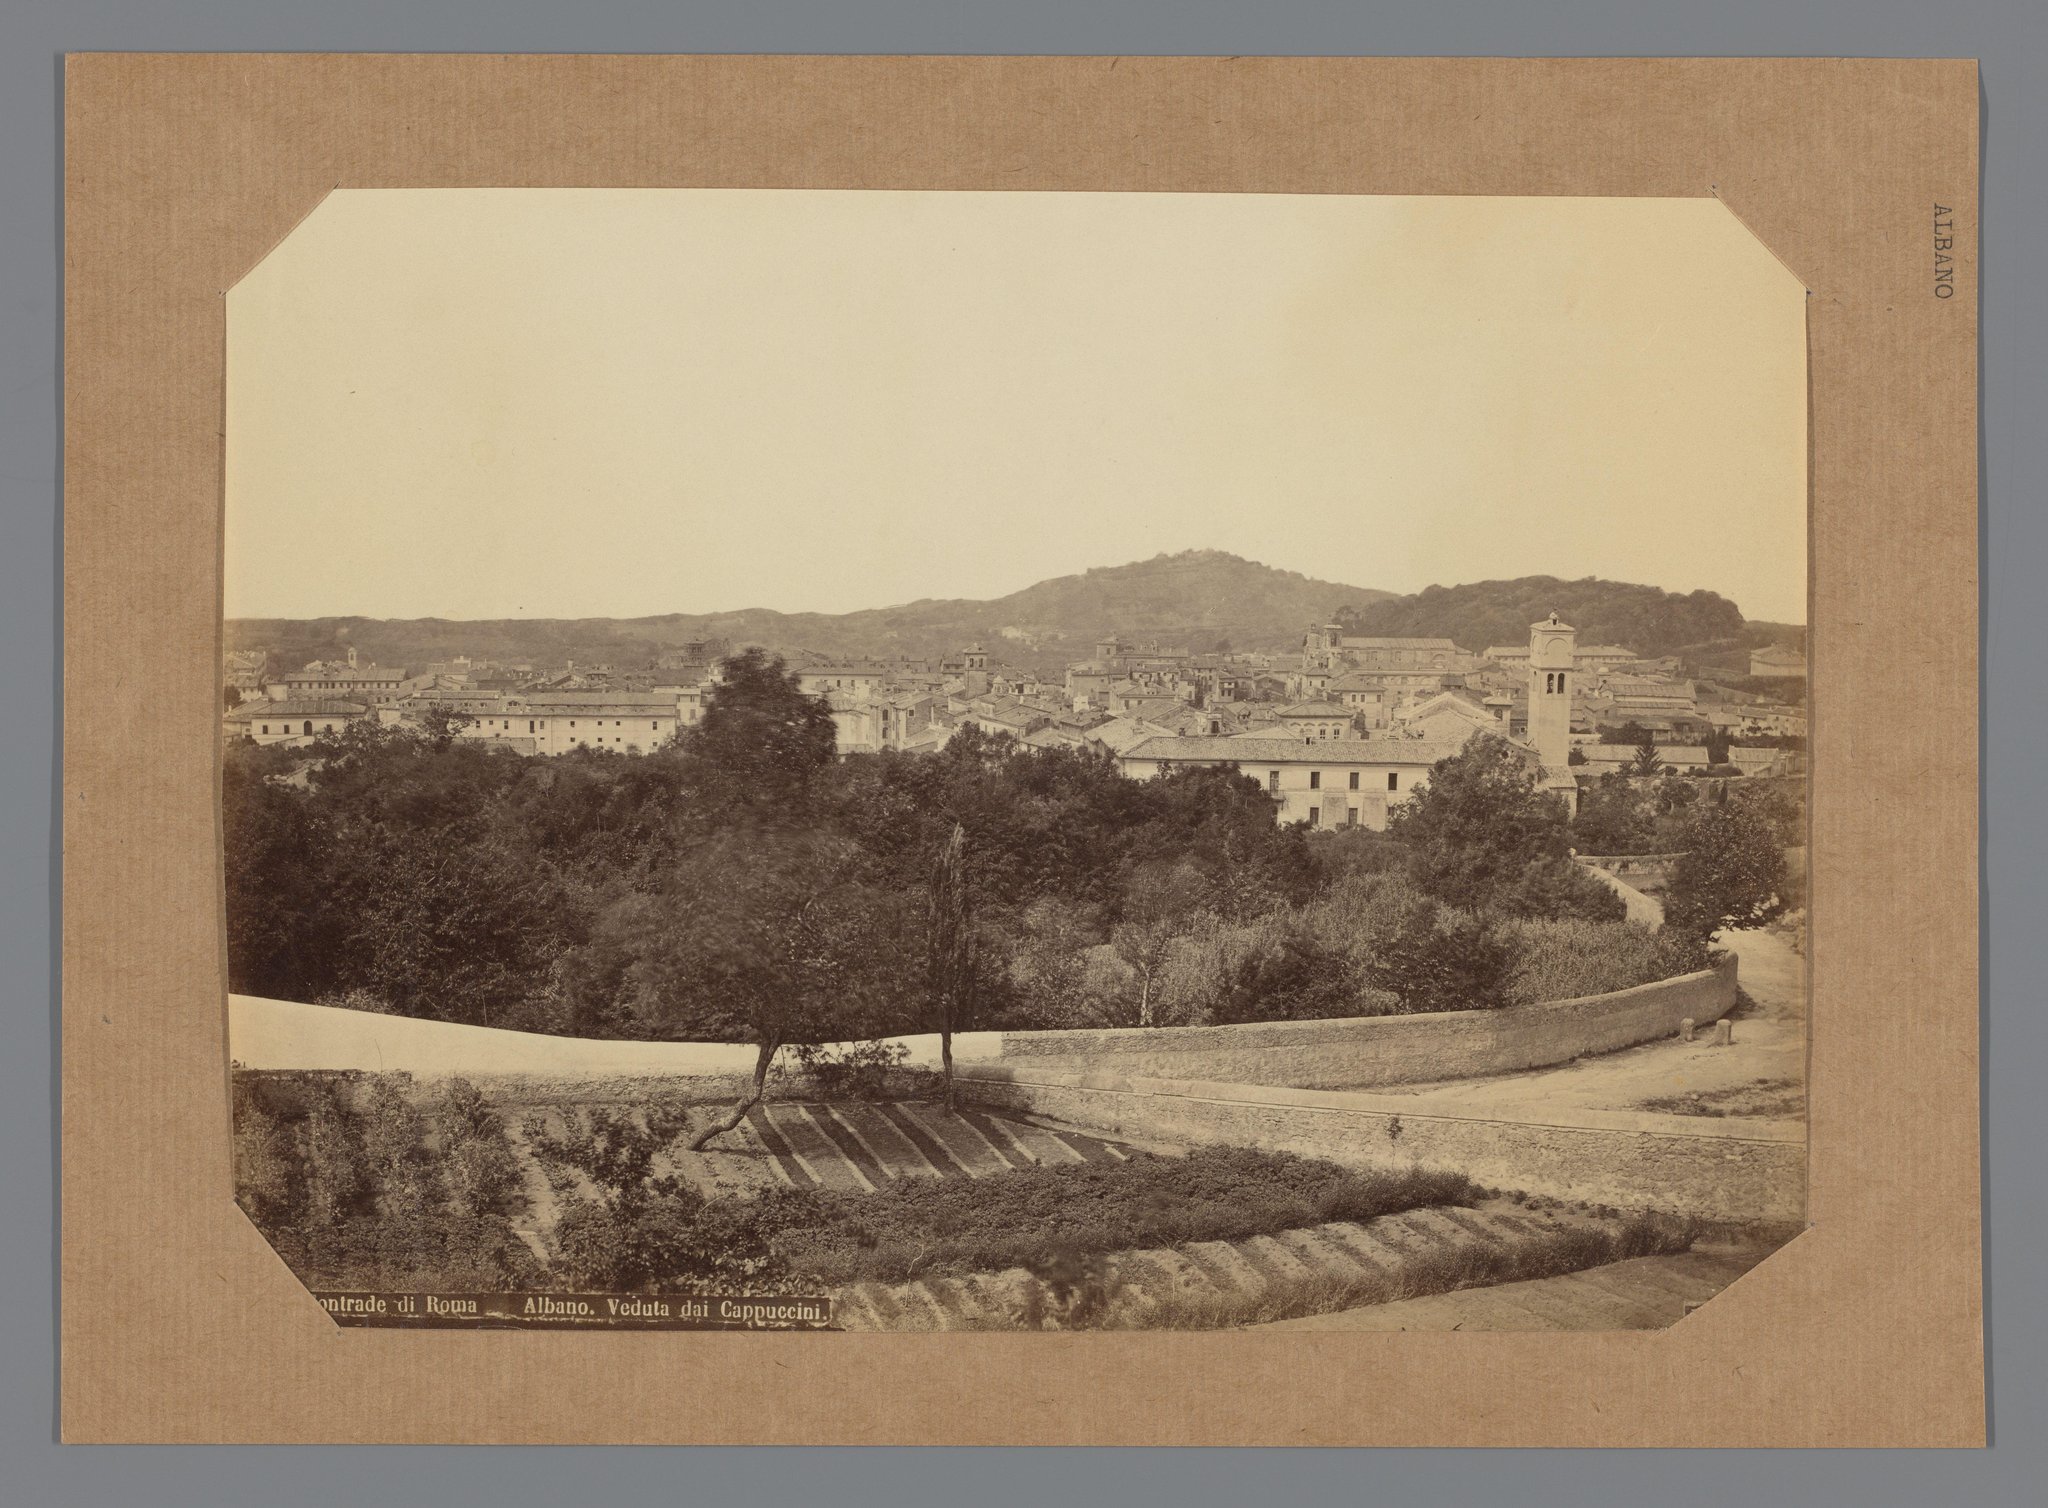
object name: photograph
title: Italië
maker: Anonymous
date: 1880-1910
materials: photographic support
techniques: albumen print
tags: italy